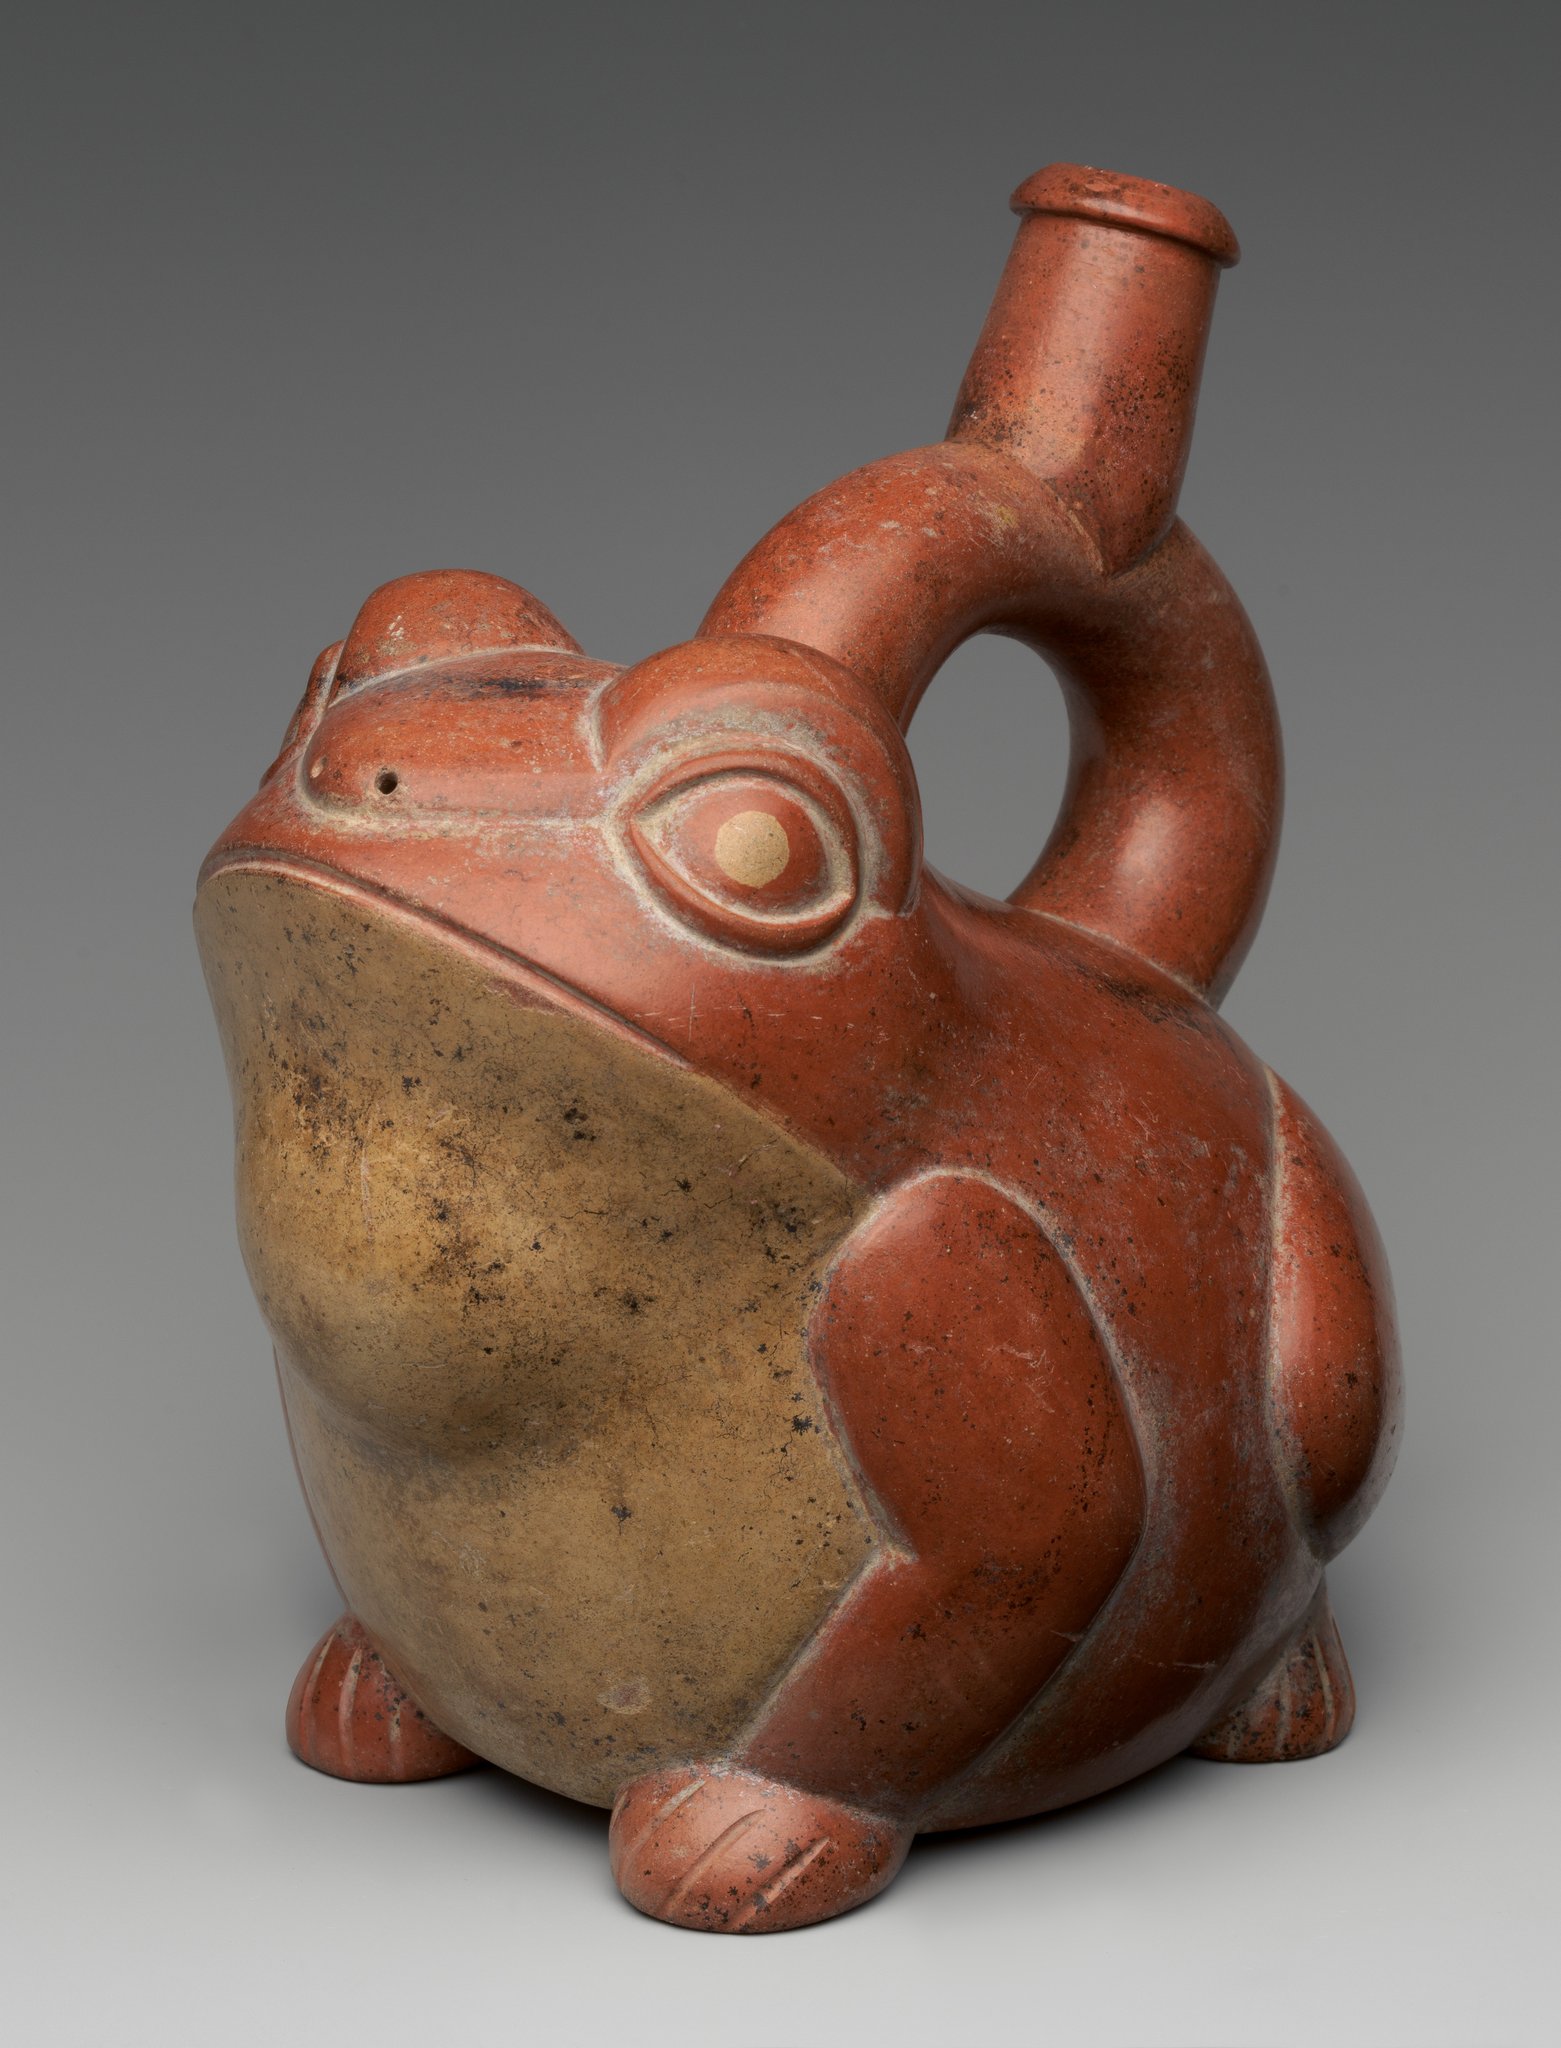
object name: bottle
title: Stirrup Spout Bottle: Frog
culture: moche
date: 101-500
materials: ceramic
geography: peru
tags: frogs